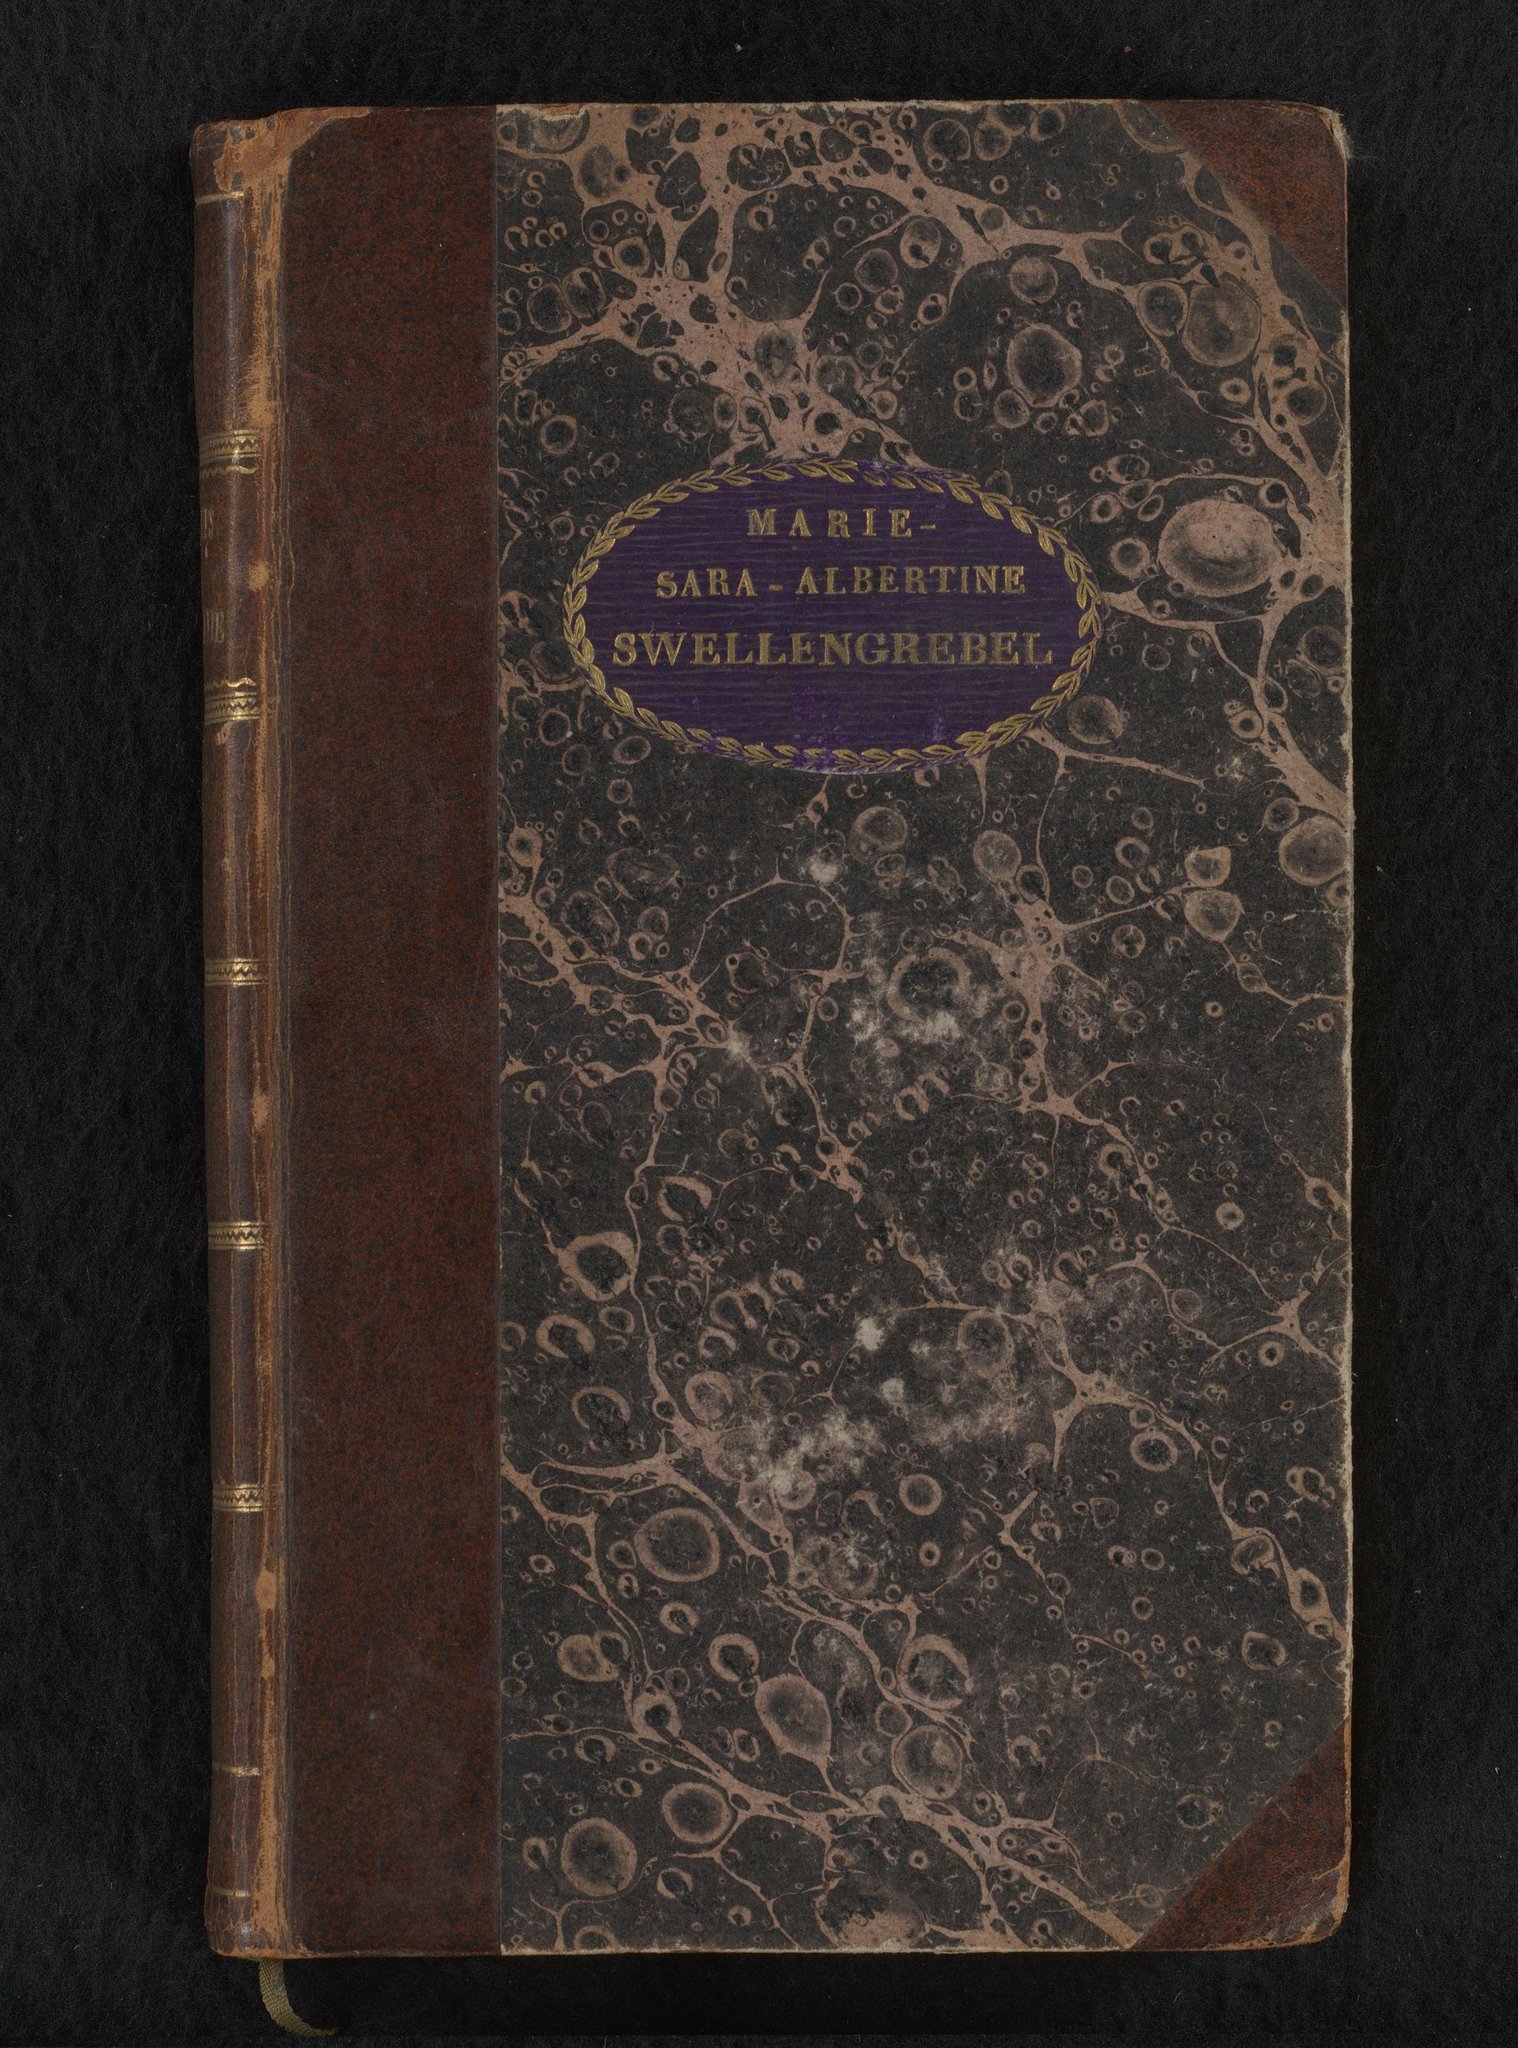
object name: book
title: Lettres d'Octavie, jeune pensionnaire de la Maison de Saint-Clair, ou Essai sur l'Education des Demoiselles; par Mme. de Renneville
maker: villet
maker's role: publisher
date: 1818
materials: leather, paper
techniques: letterpress printing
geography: paris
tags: utrecht, maria sara albertina swellengrebel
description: Lettres d'Octavie. Boek uit het bezit van Marie Sara Albertine Swellengrebel. Gebonden met de titel op de rug en de naam van de eigenares in een ovaal vignet op de voorkant.